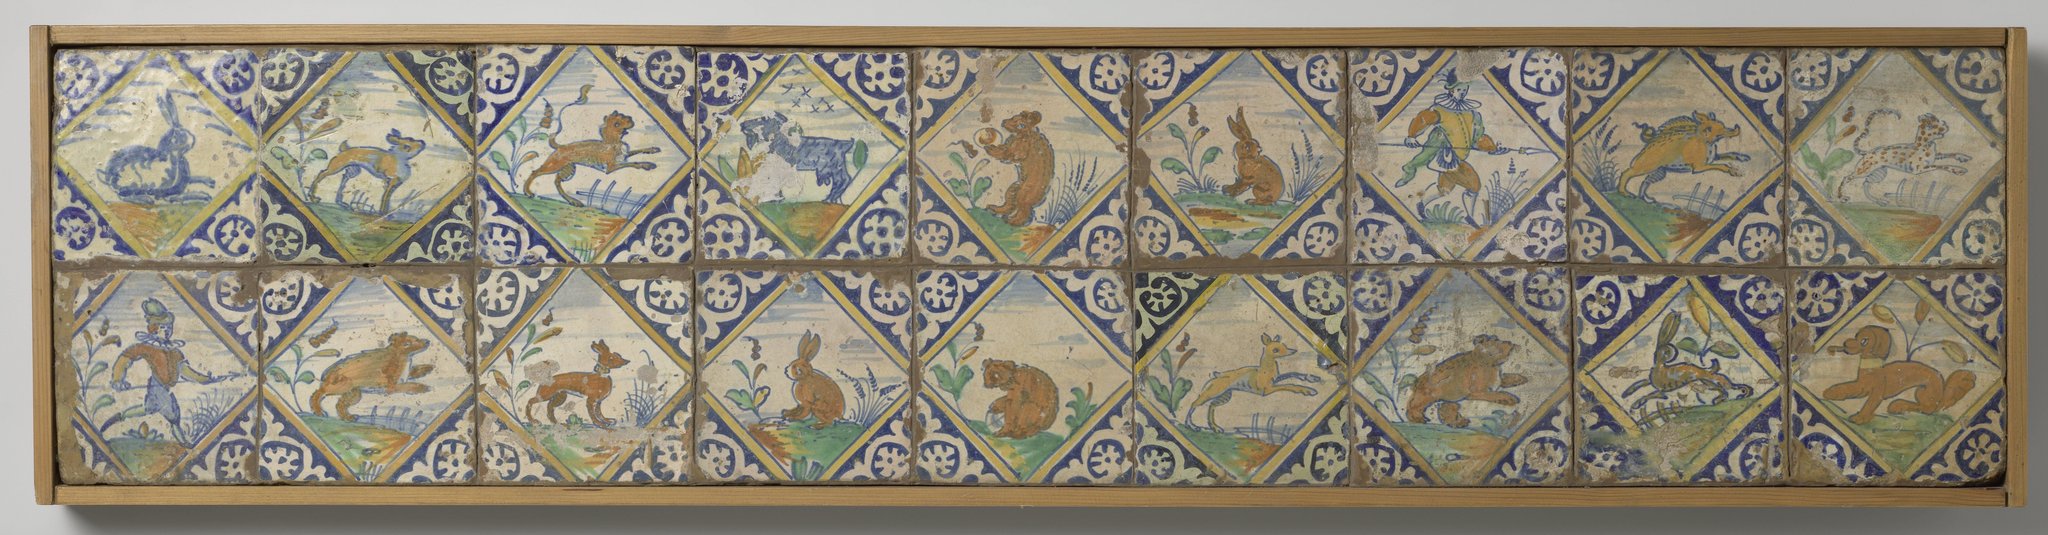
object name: tegelveld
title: Veld van achttien tegels met dieren en één jager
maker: Anonymous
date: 1580-1625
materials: earthenware, glaze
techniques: maiolica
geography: netherlands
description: Veld van achttien tegels (2 x 9) elk met een veelkleurig (blauw, oranje, geel, groen, paars) geschilderd dier (waarvan één tegel met jager) binnen een kwadraat omlijsting. In de hoeken, vultechniek ornament.